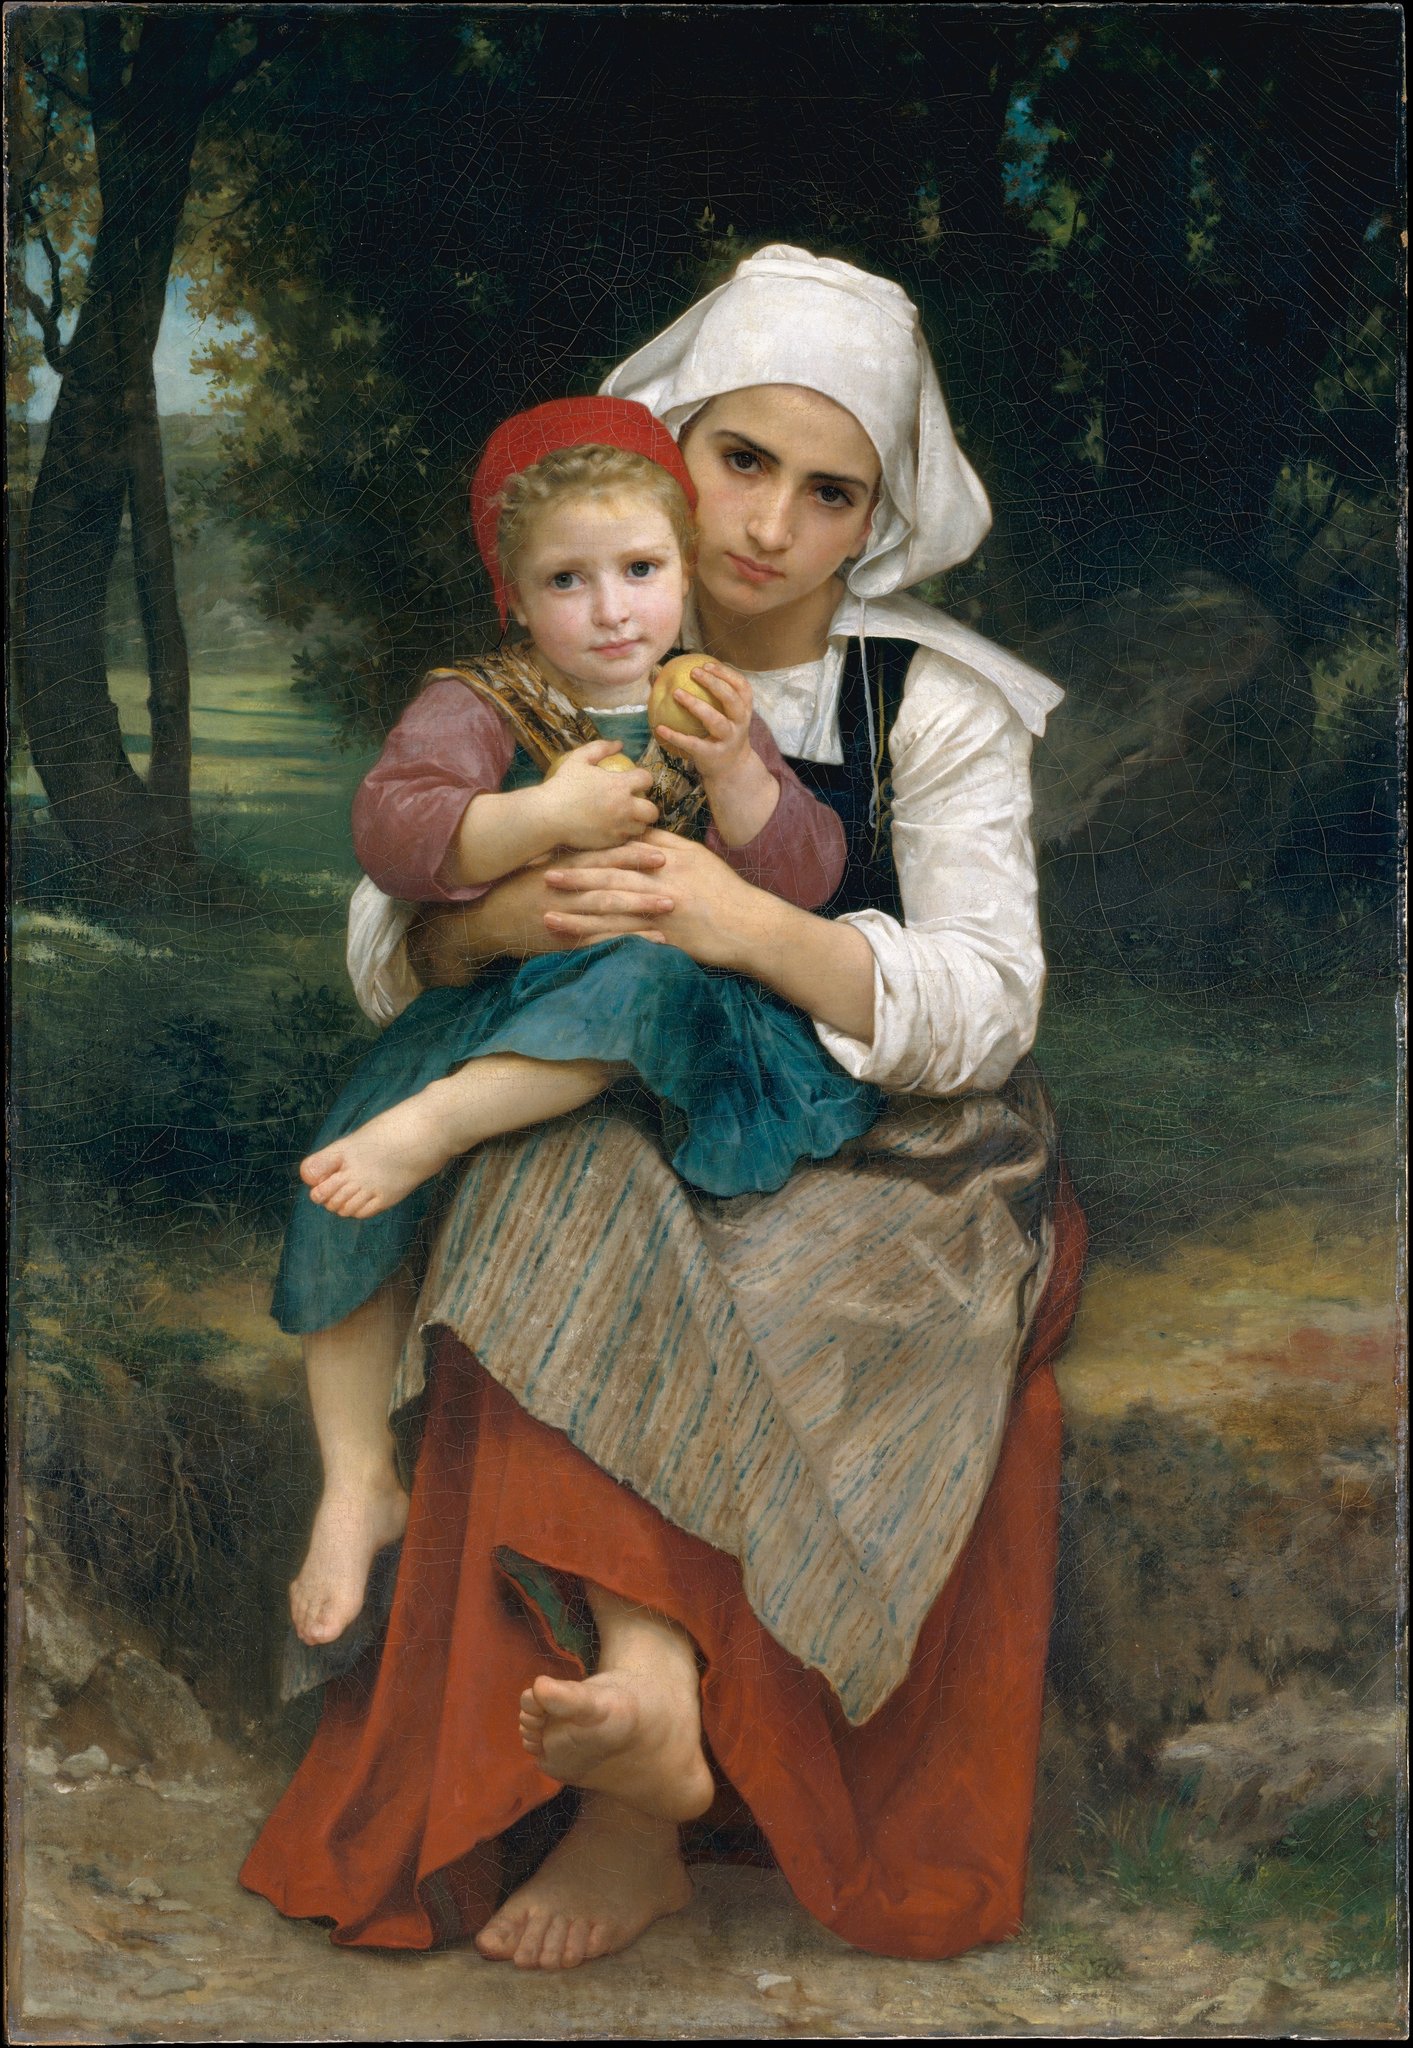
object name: painting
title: Breton Brother and Sister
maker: william bouguereau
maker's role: artist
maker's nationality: french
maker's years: 1825-1905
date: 1871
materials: canvas, oil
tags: boys,girls,portraits